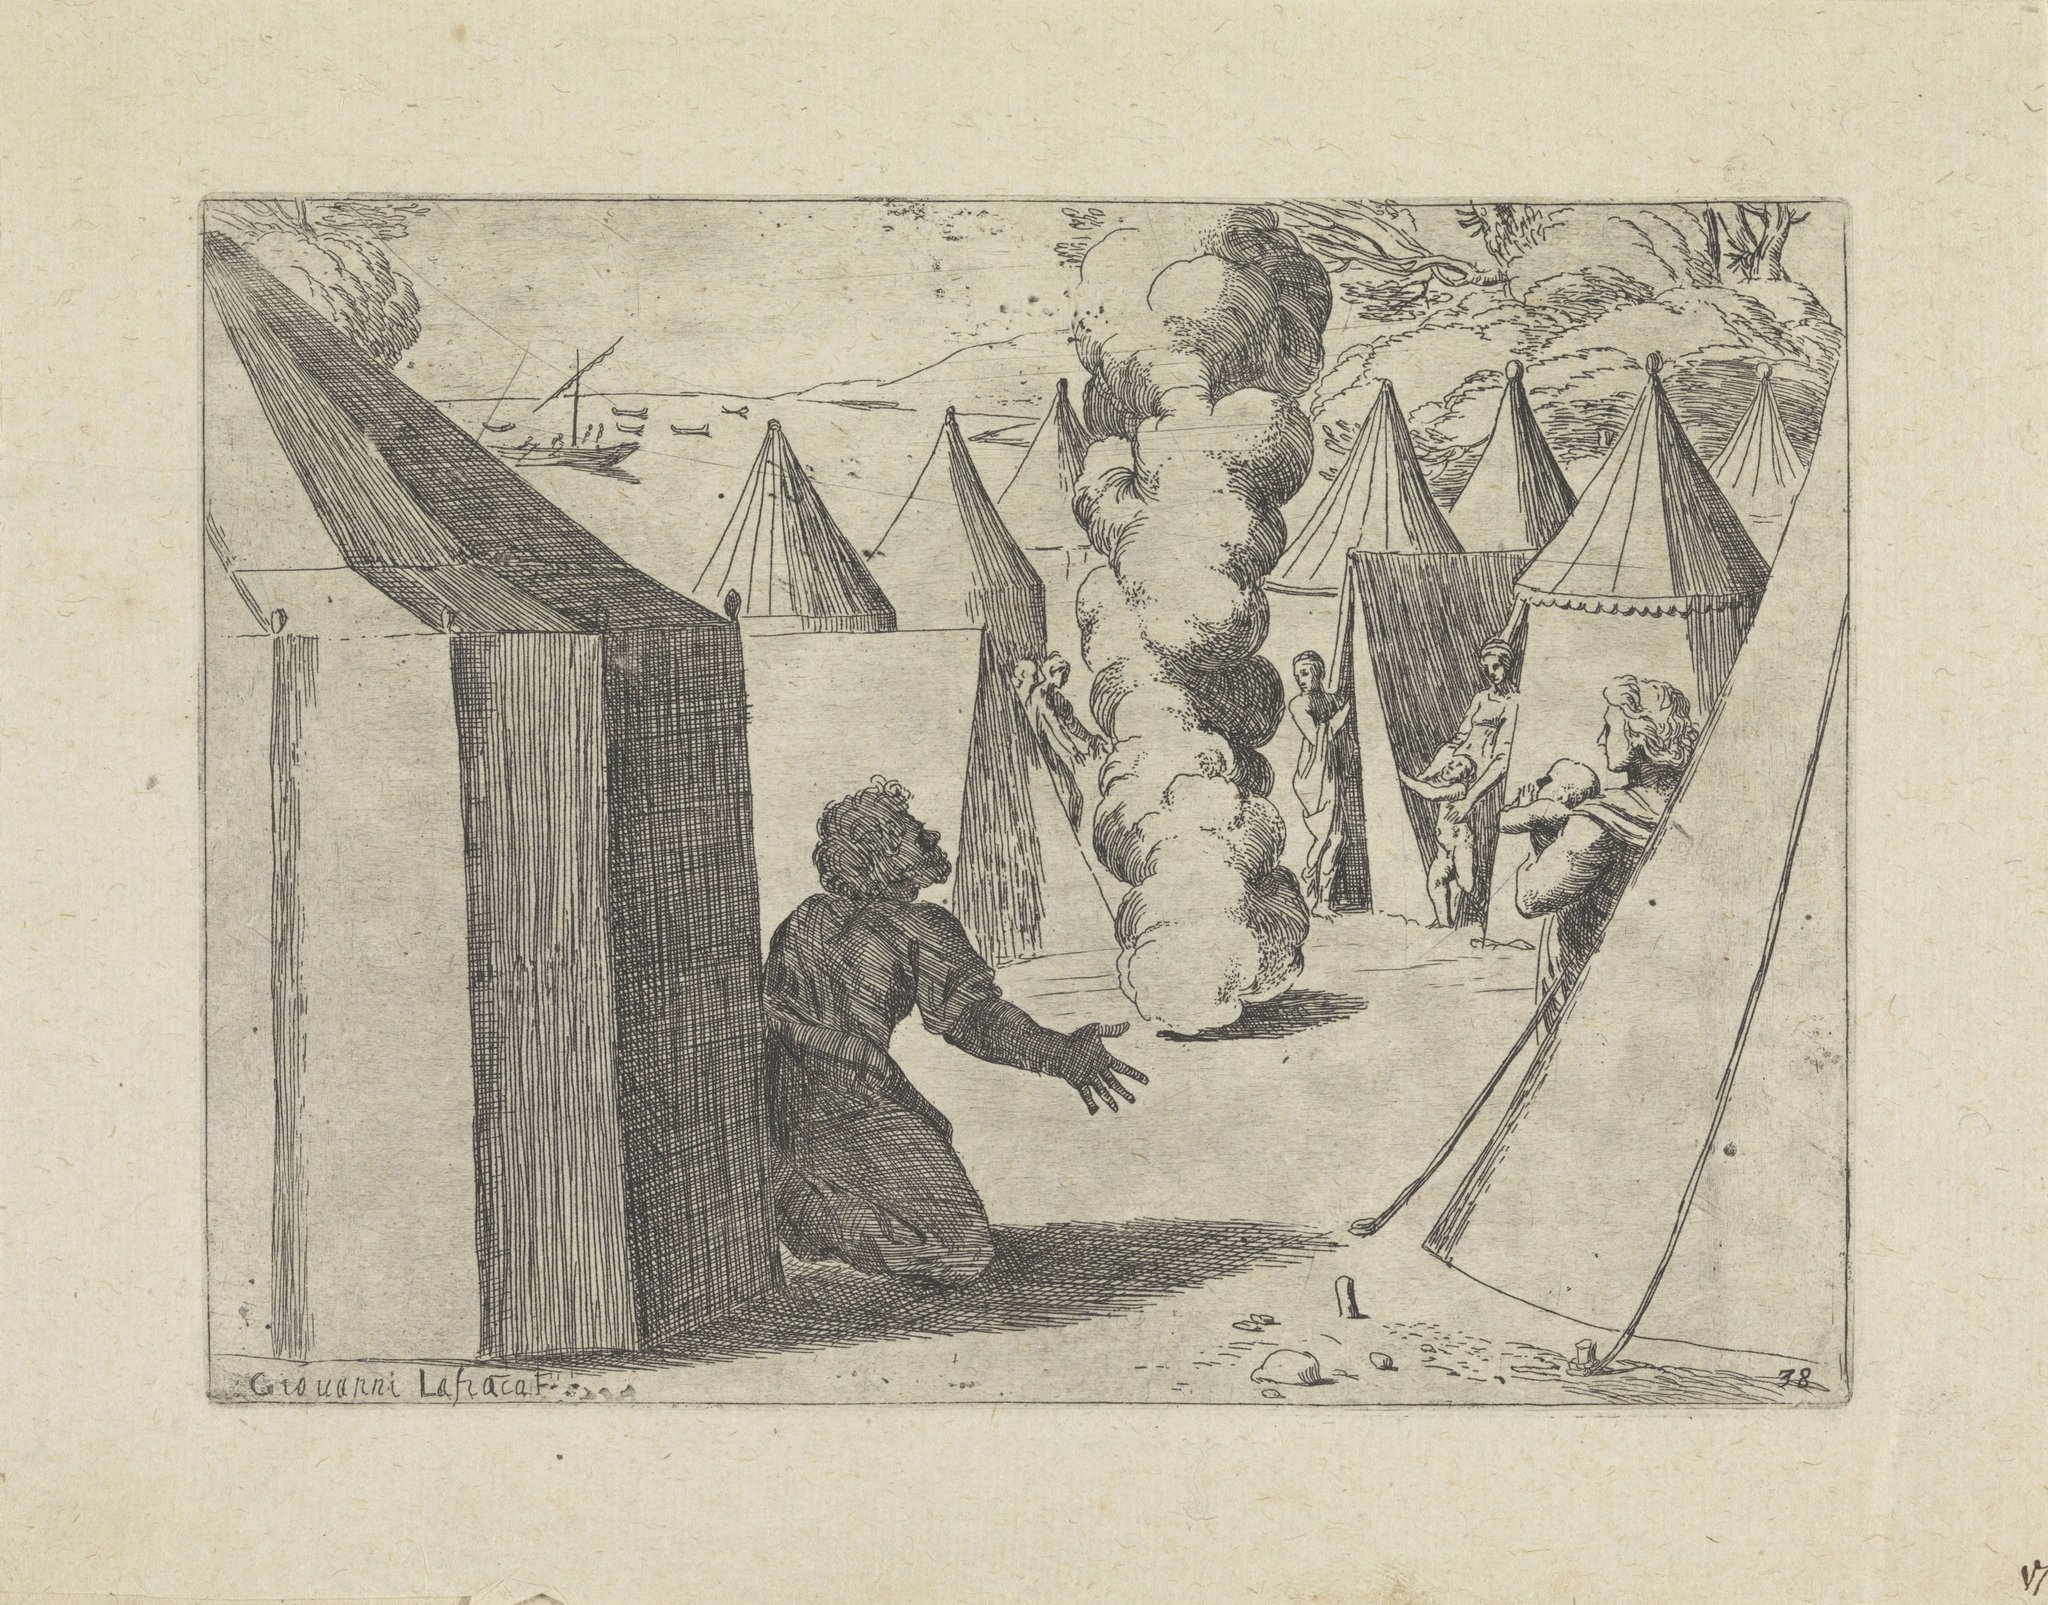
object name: print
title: God verschijnt aan Mozes in een rookkolom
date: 1607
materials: paper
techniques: etching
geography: italy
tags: god comes down in the pillar of cloud at the door of the tabernacle and rebukes aaron and miriam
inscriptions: number: ‘17’, collector's mark: ‘Hinloopen’, collector's mark: Lugt 11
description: Op een blad geplakt met rechtsboven handgeschreven in pen in bruin: 137. Prent uit een reeks van 54 genummerde prenten naar schilderingen in de Loggia van Rafael in het Vaticaan.